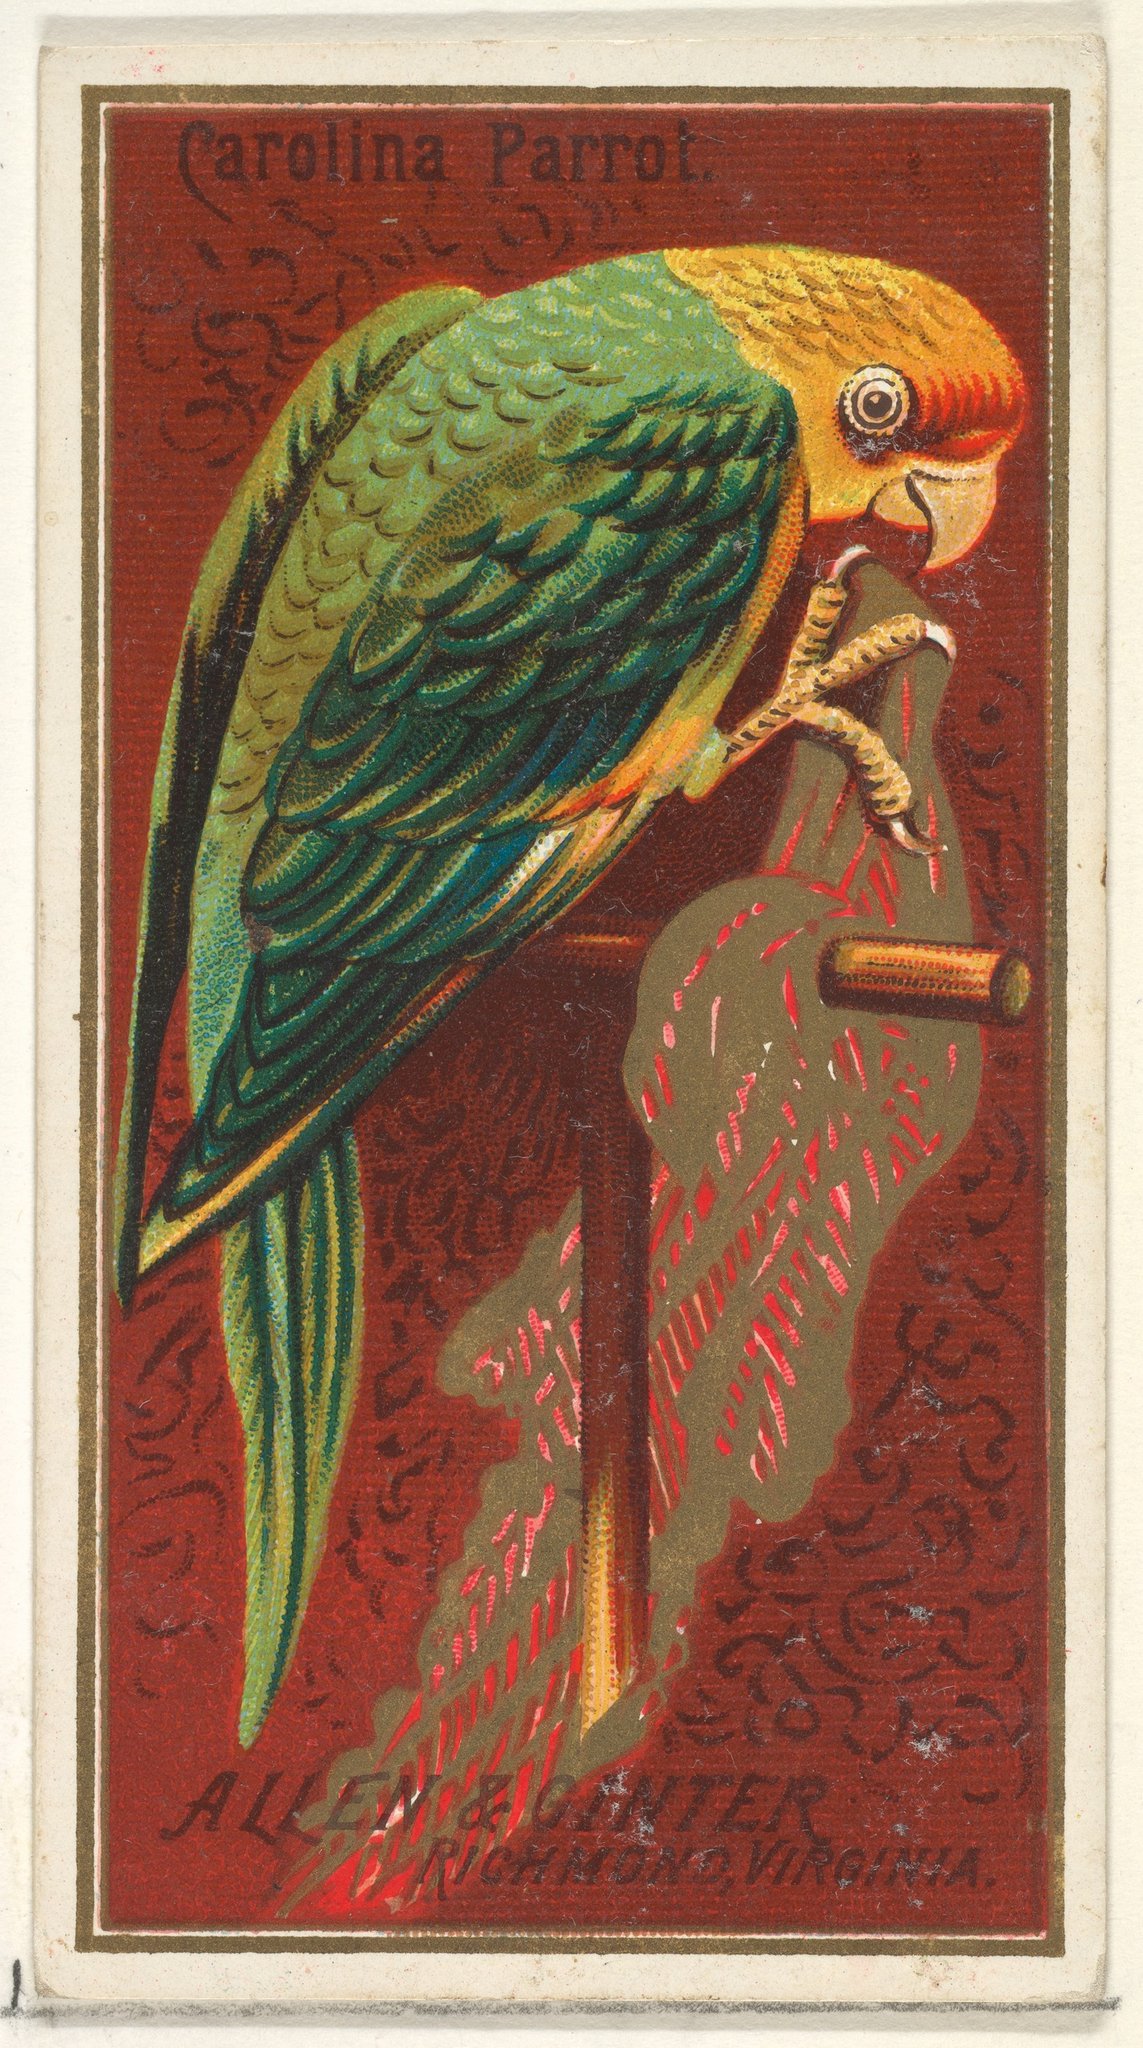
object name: print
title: Carolina Parrot, from the Birds of America series (N4) for Allen & Ginter Cigarettes Brands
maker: allen & ginter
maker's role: publisher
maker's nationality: american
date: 1888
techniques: color lithograph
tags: parrots